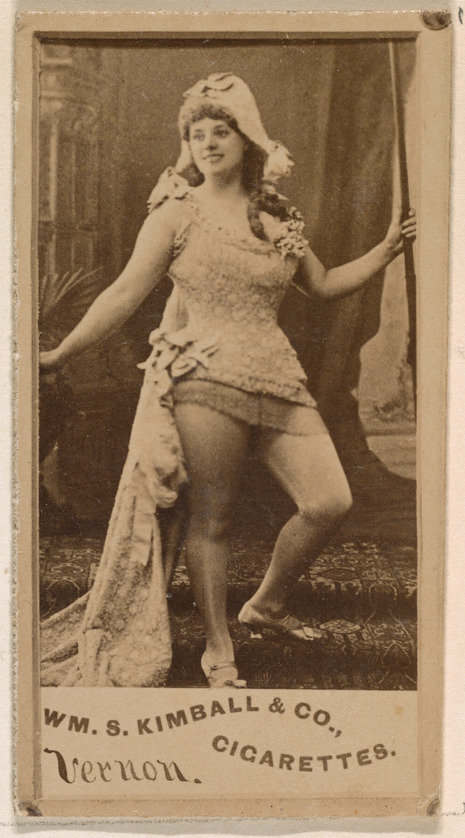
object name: photograph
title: Miss Vernon, from the Actresses series (N203) issued by Wm. S. Kimball & Co.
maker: william s. kimball & company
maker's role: publisher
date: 1889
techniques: color lithograph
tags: portraits,women,actresses